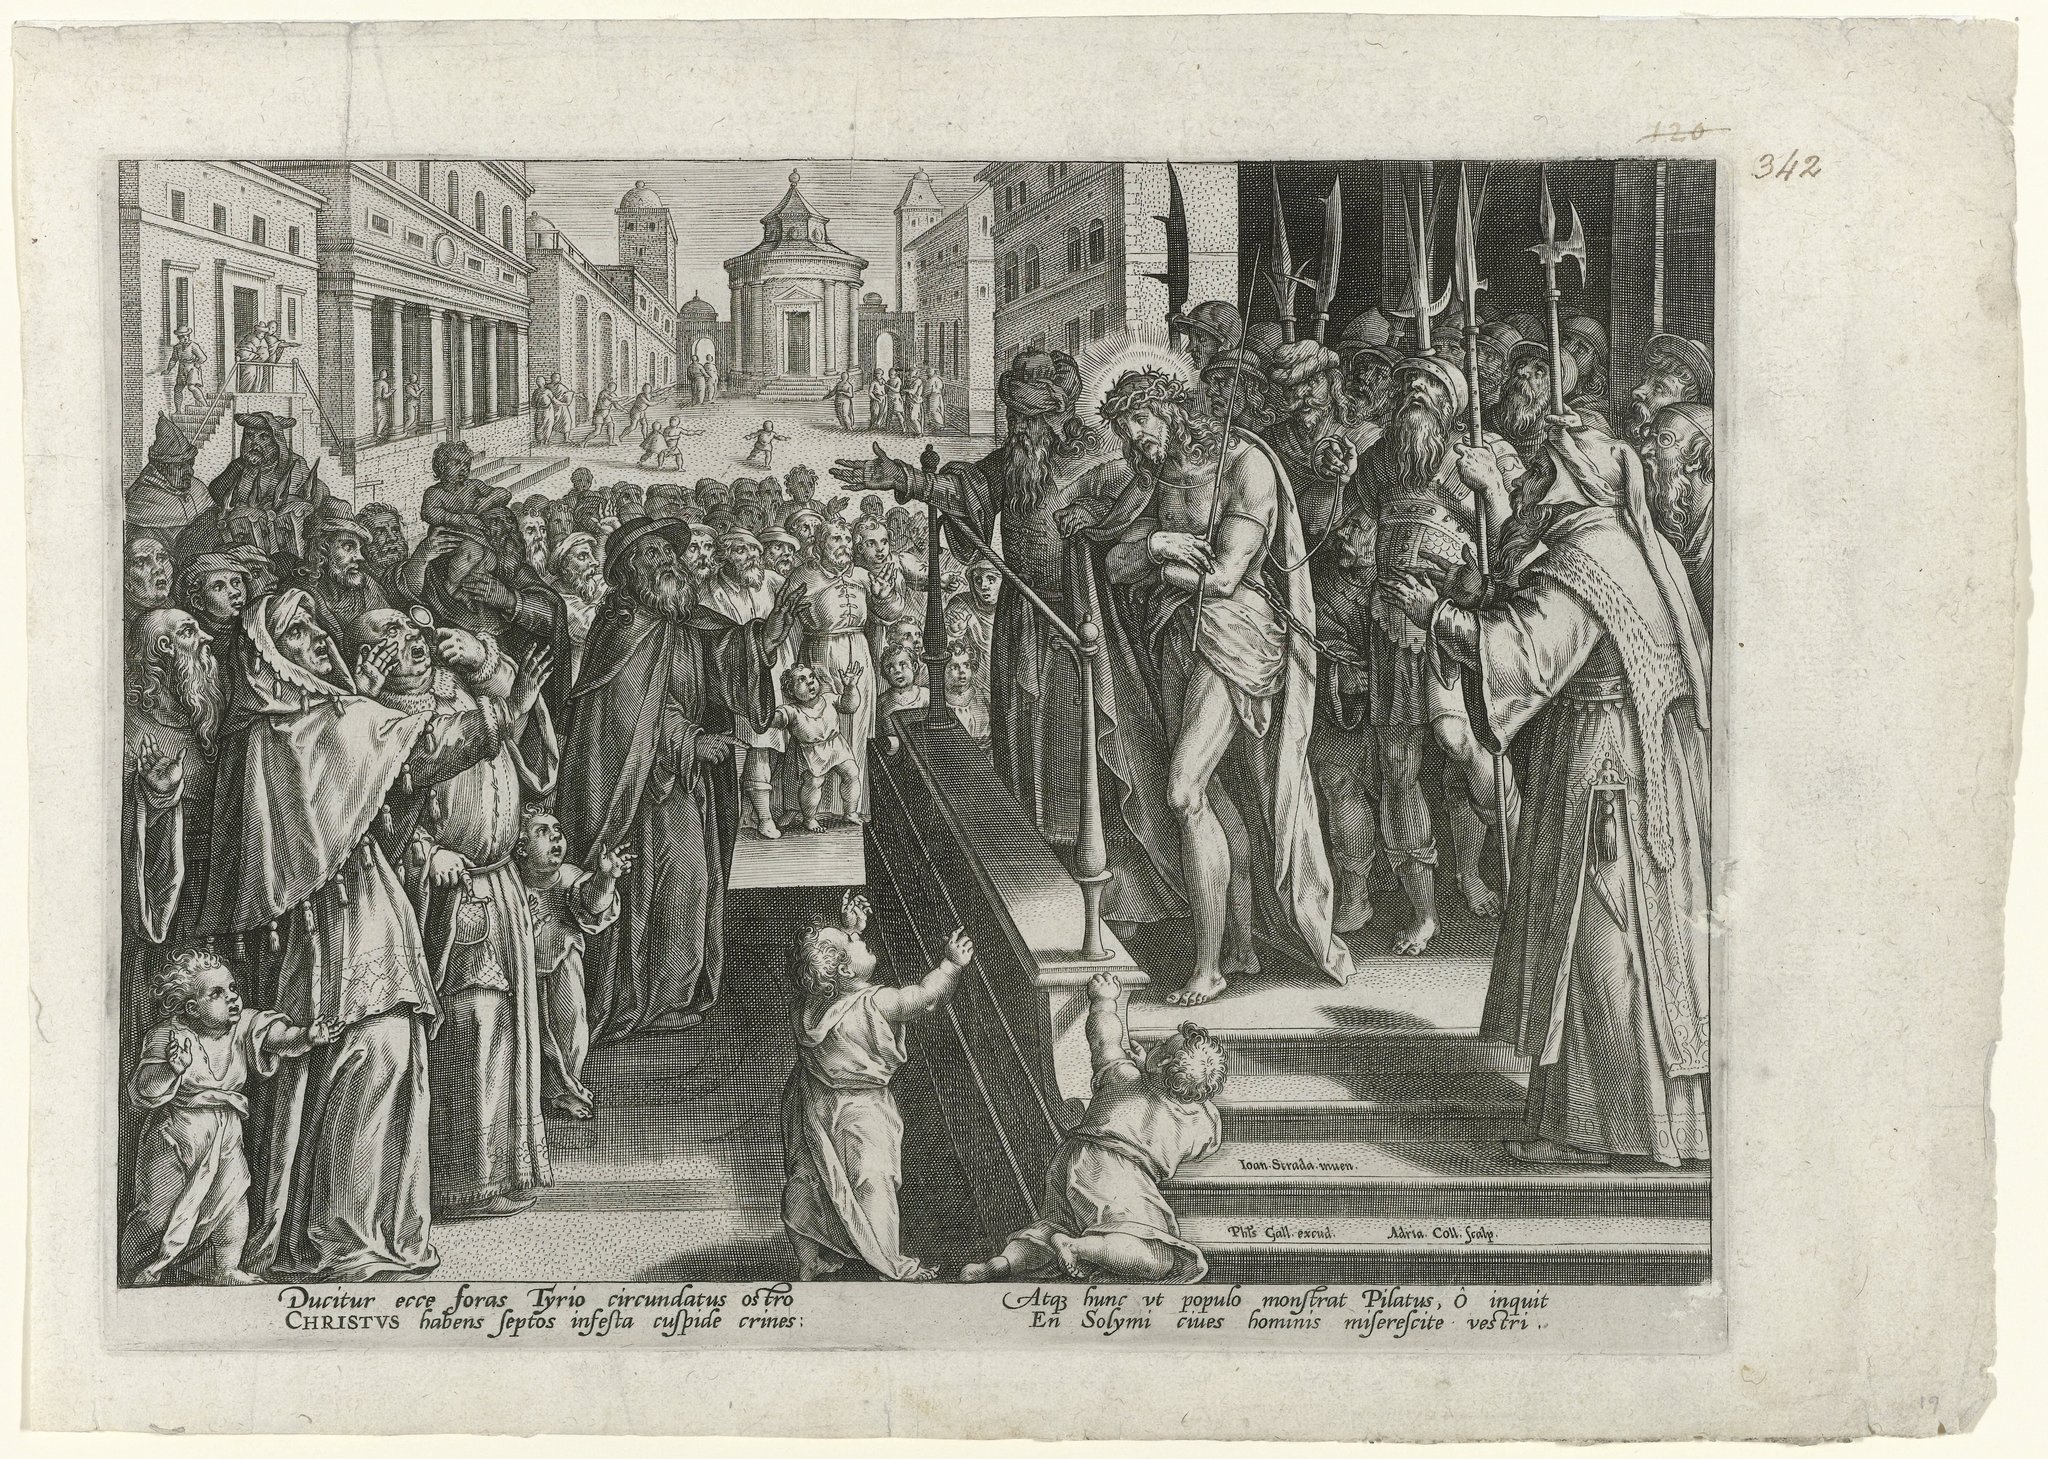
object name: print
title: Ecce Homo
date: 1585-1586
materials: paper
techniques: engraving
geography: antwerp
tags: pilate showing christ to the people, 'ostentatio christi', 'ecce homo' (john 19:4-6)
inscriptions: collector's mark: 2760, number: ‘342’, collector's mark: Lugt 2228, watermark:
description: Pontius Pilatus toont de gegeselde Christus aan het Joodse volk, die hem uitjouwt (Joh. 19:4-7). De prent heeft een Latijns onderschrift en maakt deel uit van een serie over het leven van Christus.